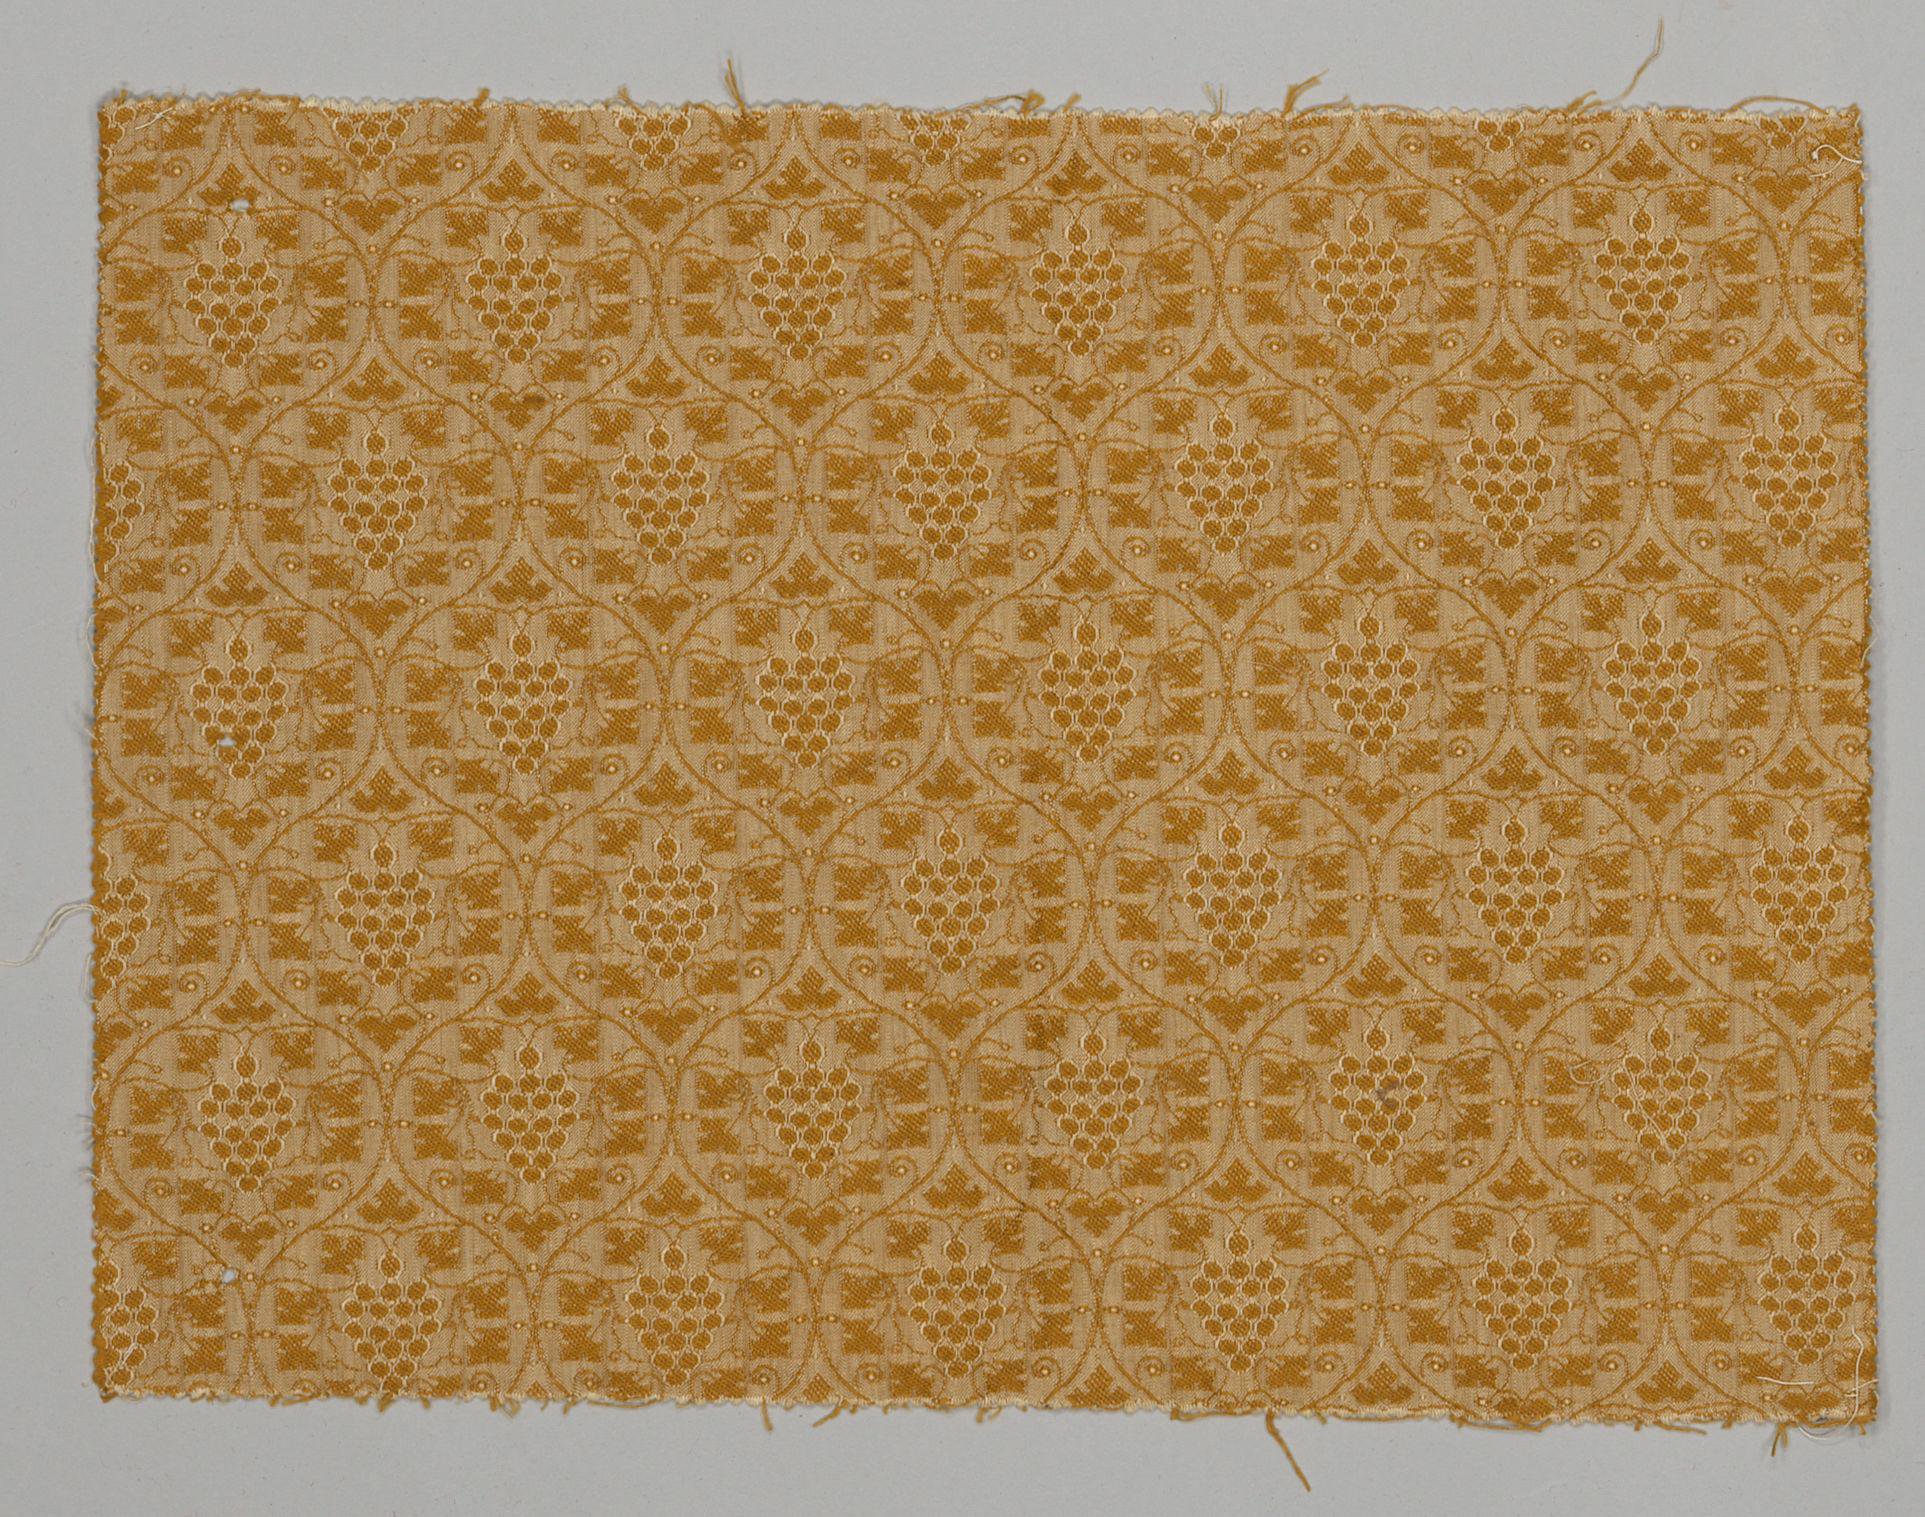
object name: sample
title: Staal bespanningsstof met druiventros binnen spitsovalen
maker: theo nieuwenhuis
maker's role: designer, draughtsman, print maker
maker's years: 1866-1951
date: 1909-1924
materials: cotton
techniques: jacquard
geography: netherlands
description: Staal katoenen gordijnstof van jacquardweefsel, goudgele inslag op naturel ketting. Klein motief.